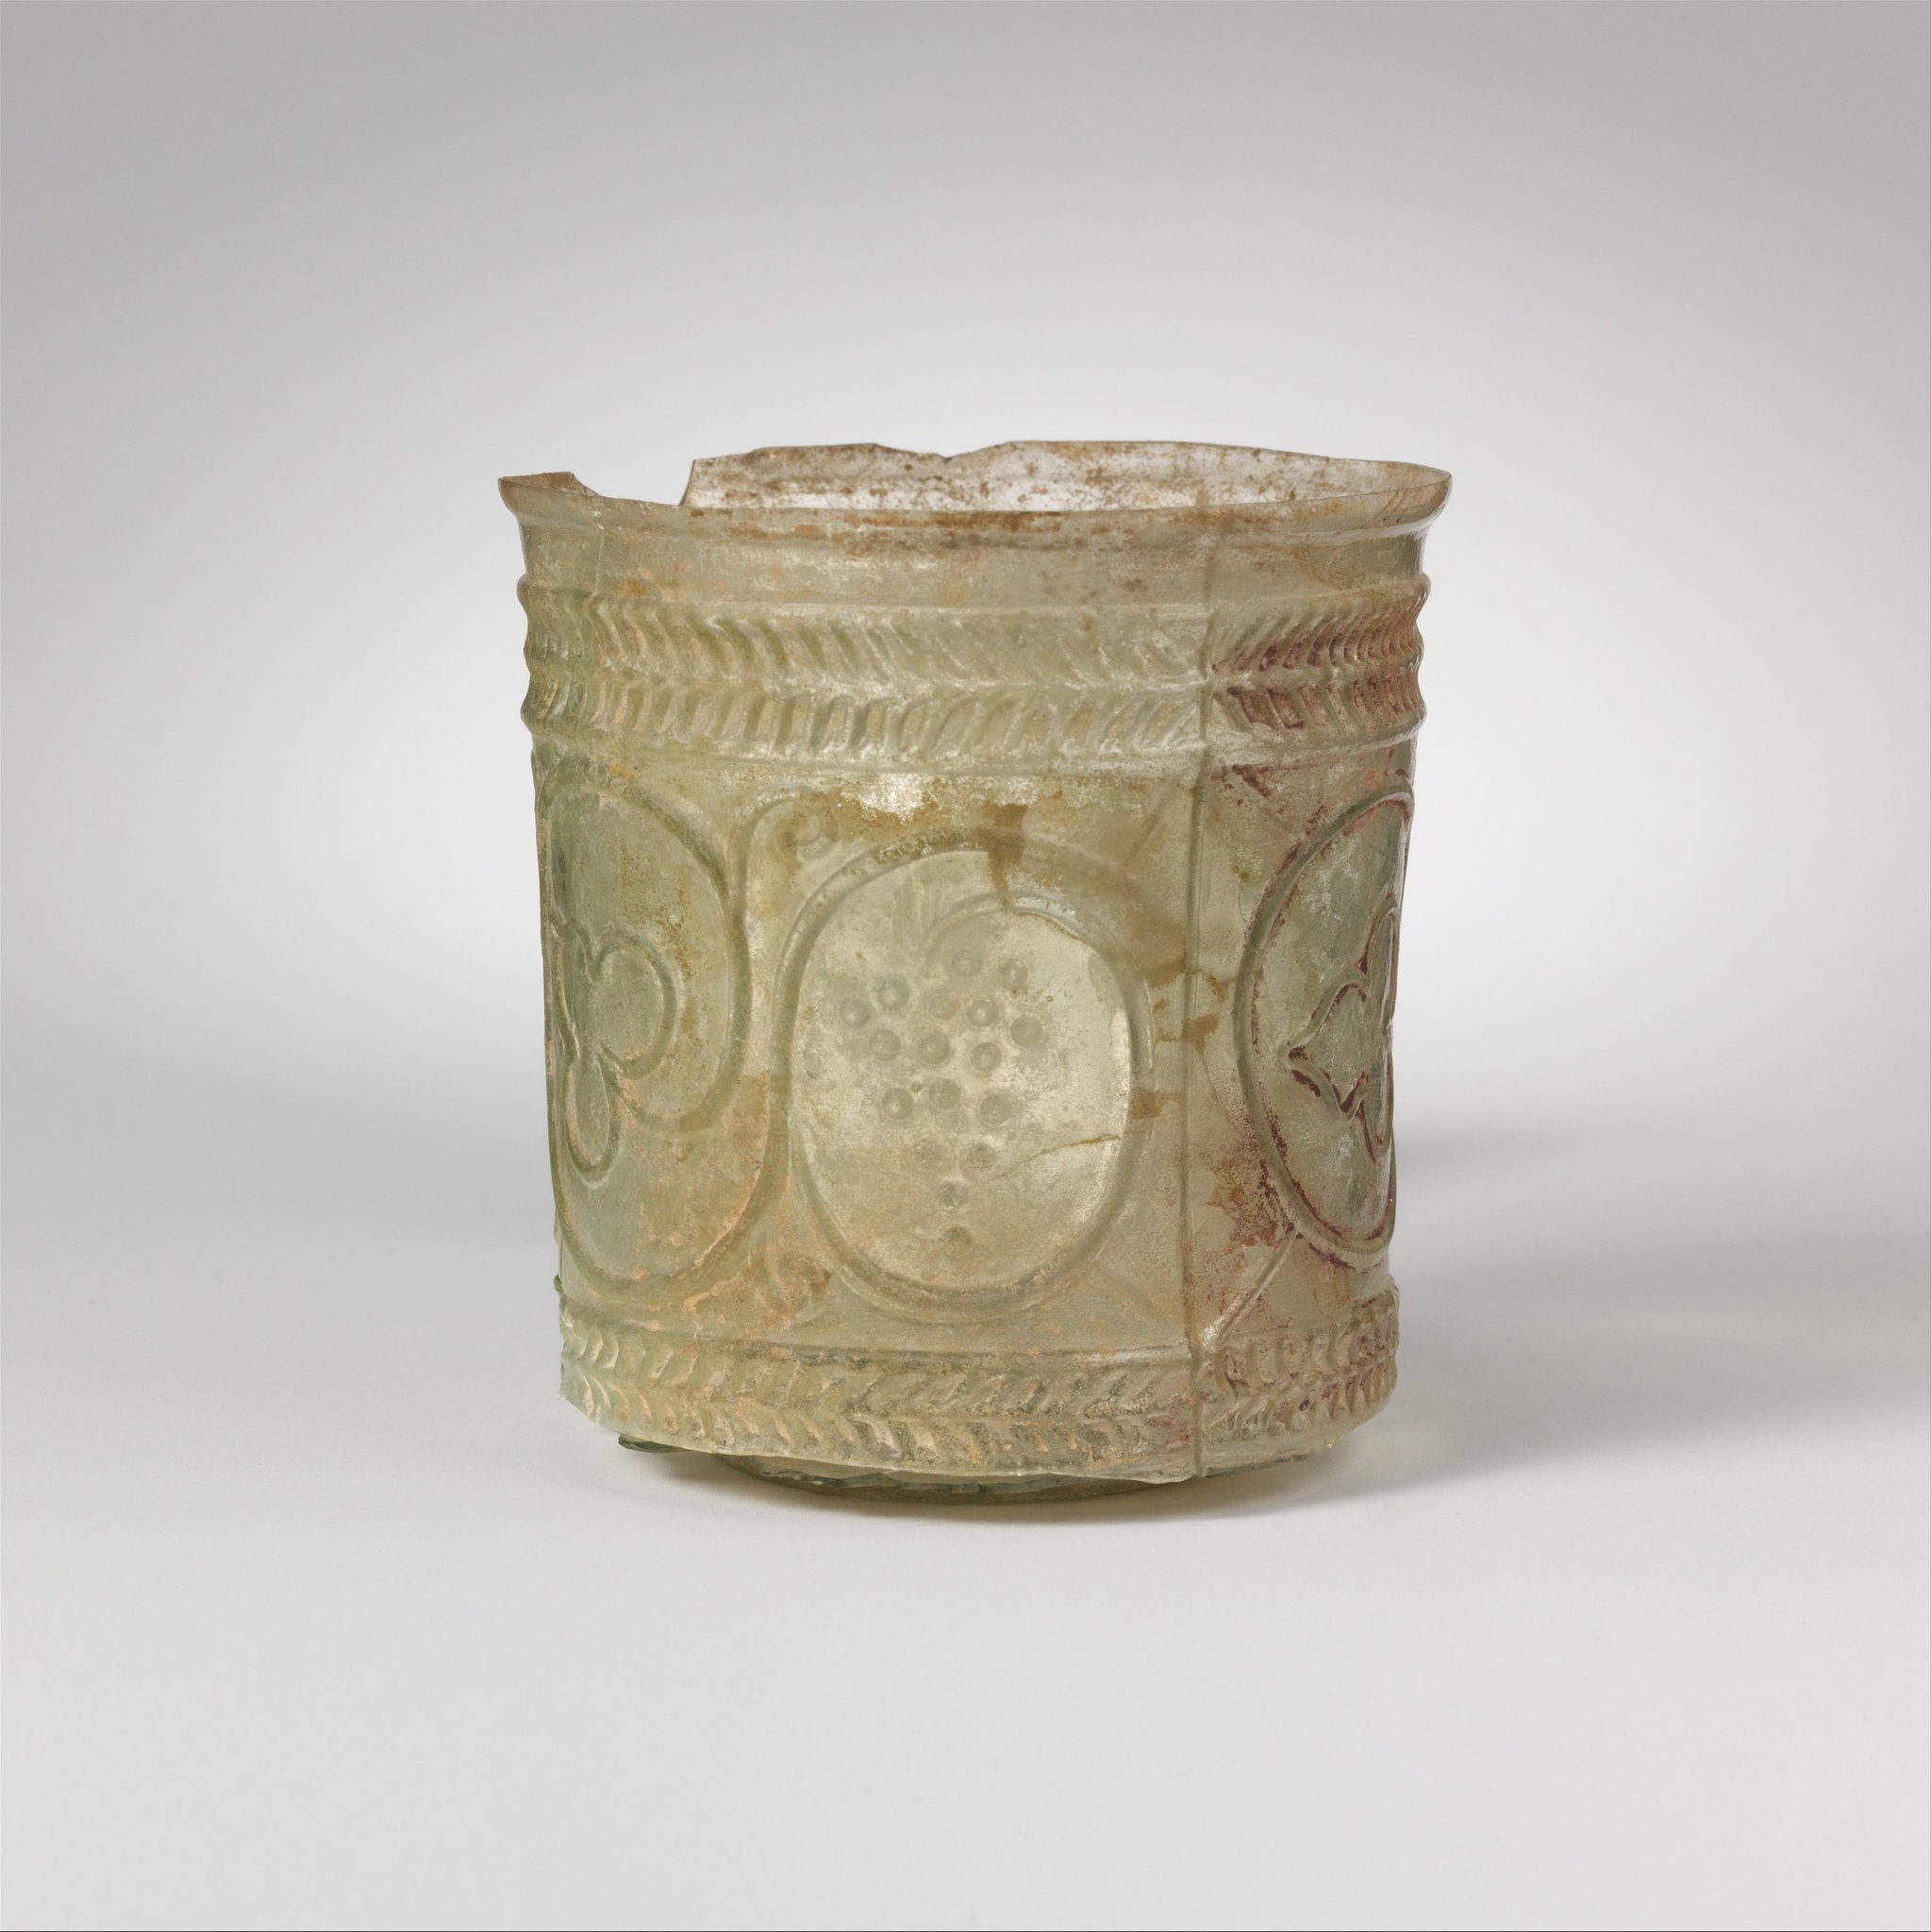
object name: beaker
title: Glass beaker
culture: roman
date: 1-50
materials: glass